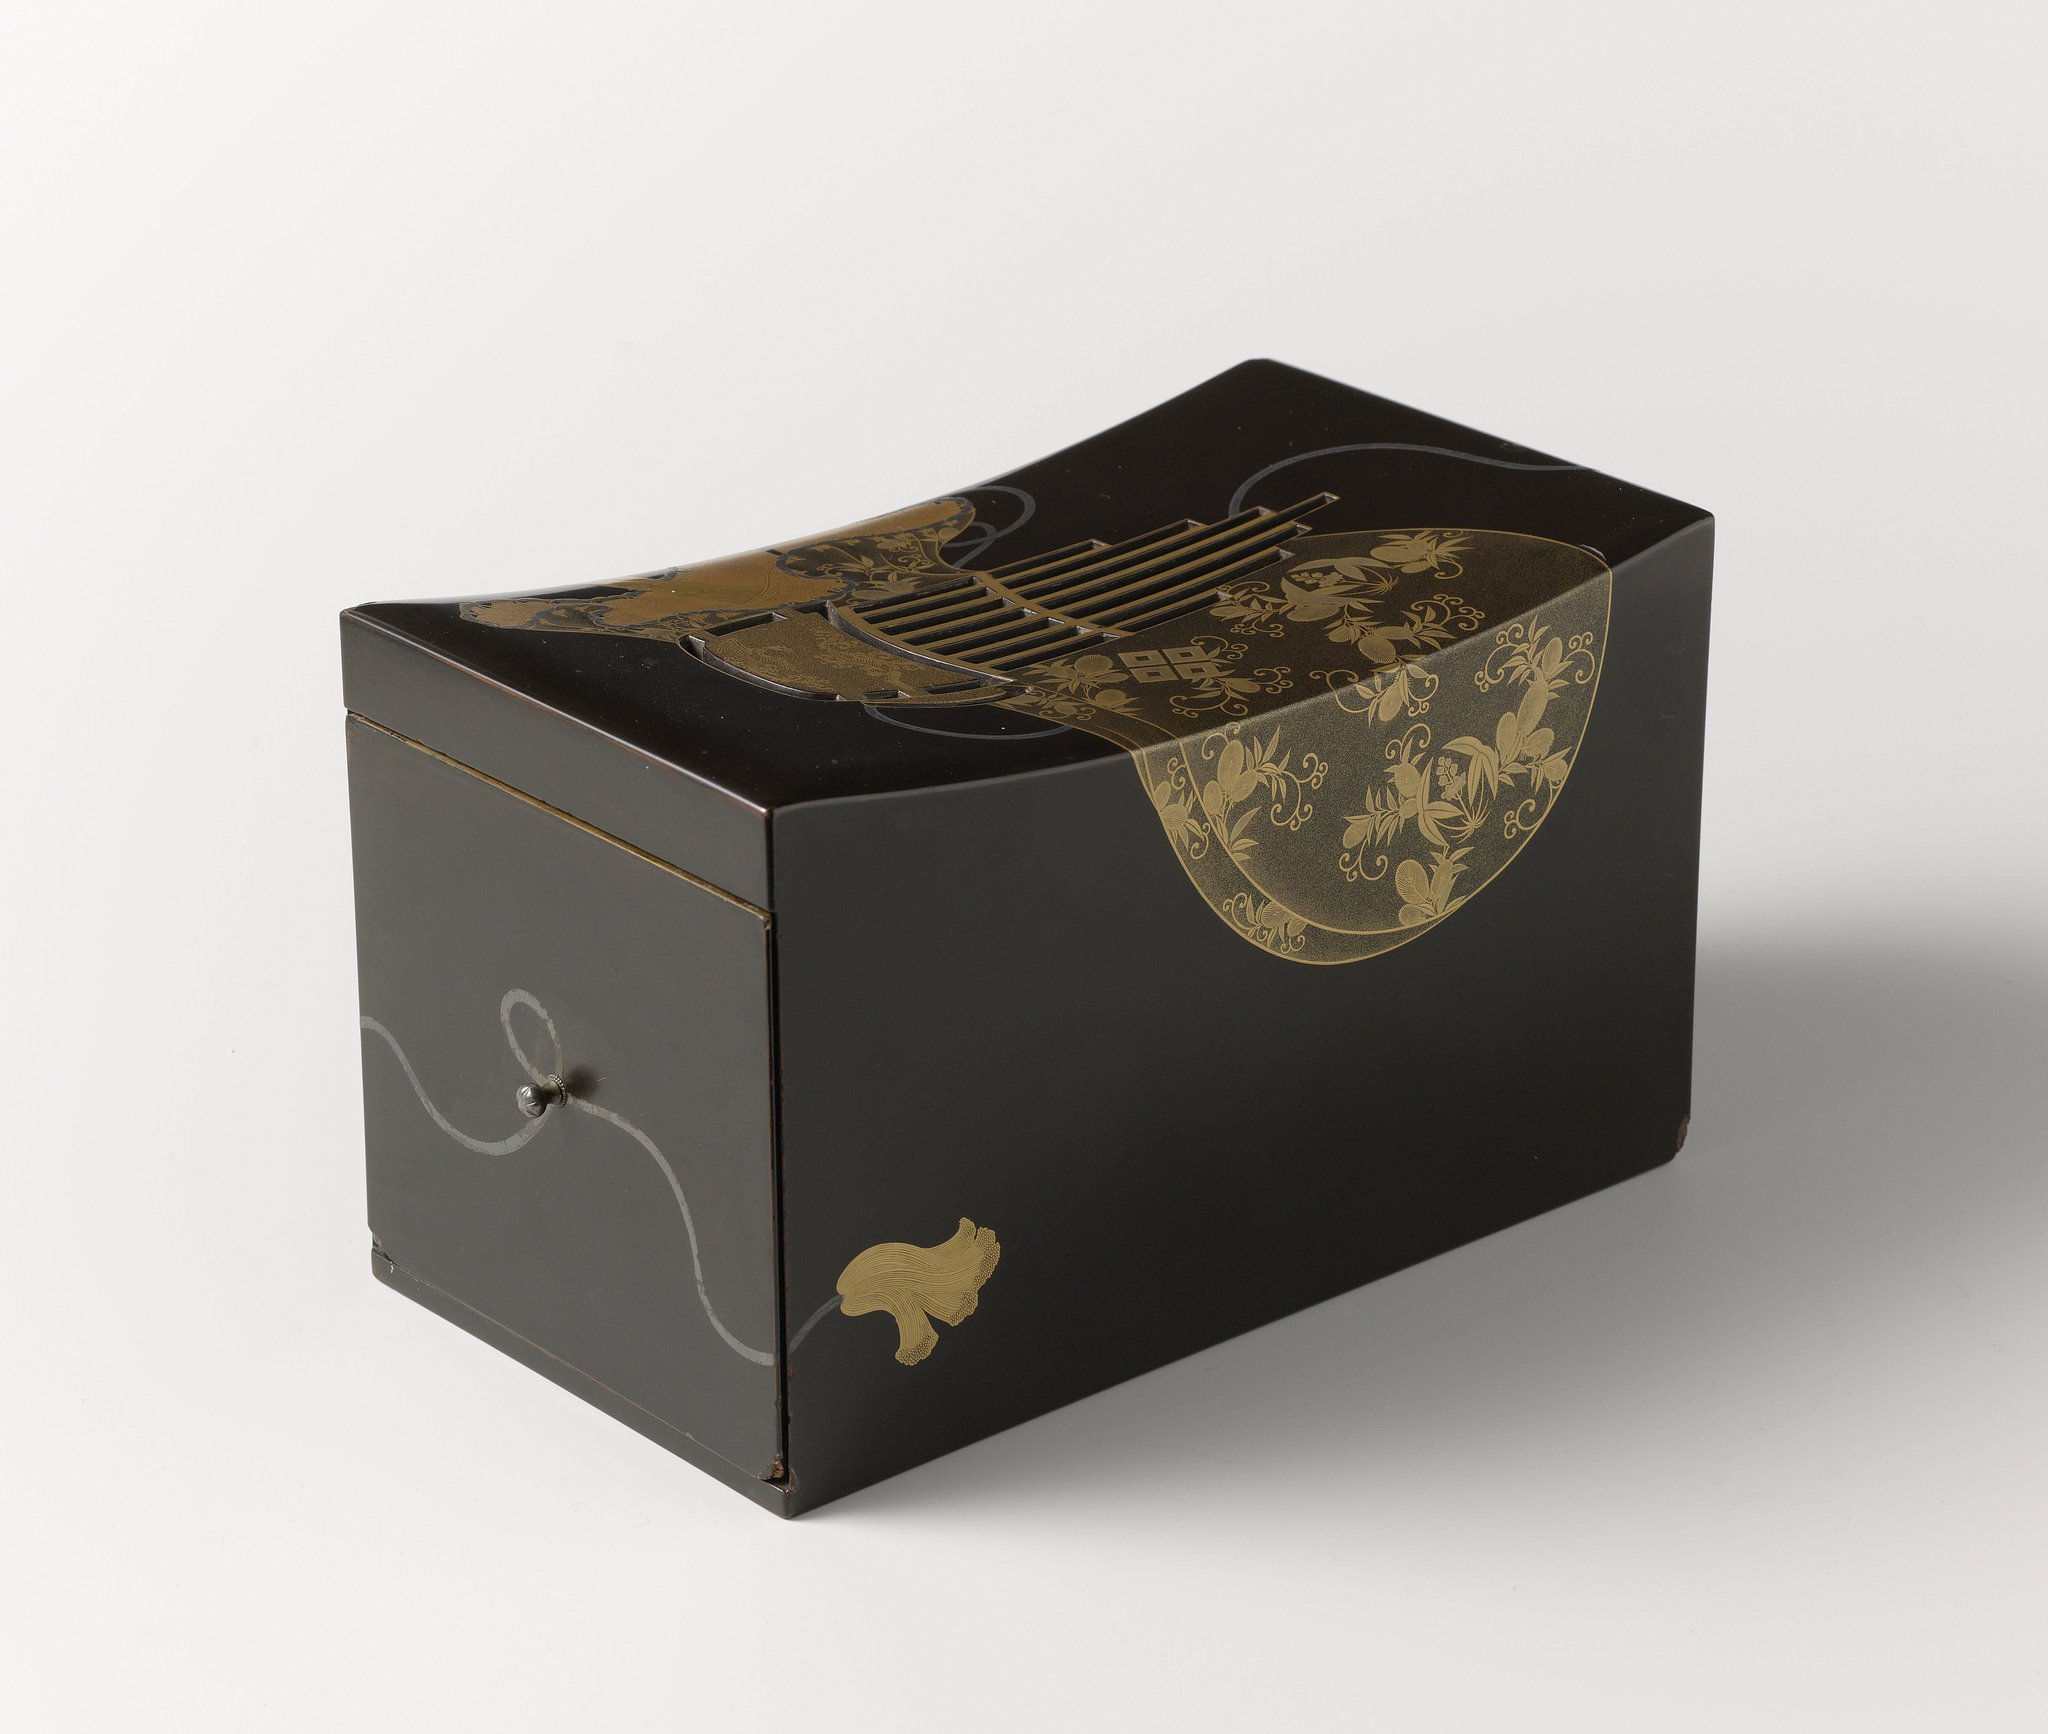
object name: pillow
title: Hoofdkussen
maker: yoyusai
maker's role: lakschilder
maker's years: 1772-1845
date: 1800-1900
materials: gold, lacquer, silver, wood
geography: japan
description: Pillow Japan 19th Century Signature: 'Yoyusai' Lacquer on wood The pillow is decorated with a bag containing alute (biwa). The openings are shaped in the form of a mouth organ (sho). Both symbols stand for a happy marriage. The two family crests on the bag further indicate that this must have been a wedding present. The drawer in the side of this 'scent pillow' could be used to hold fraganced substances that would perfume the hair during sleep.